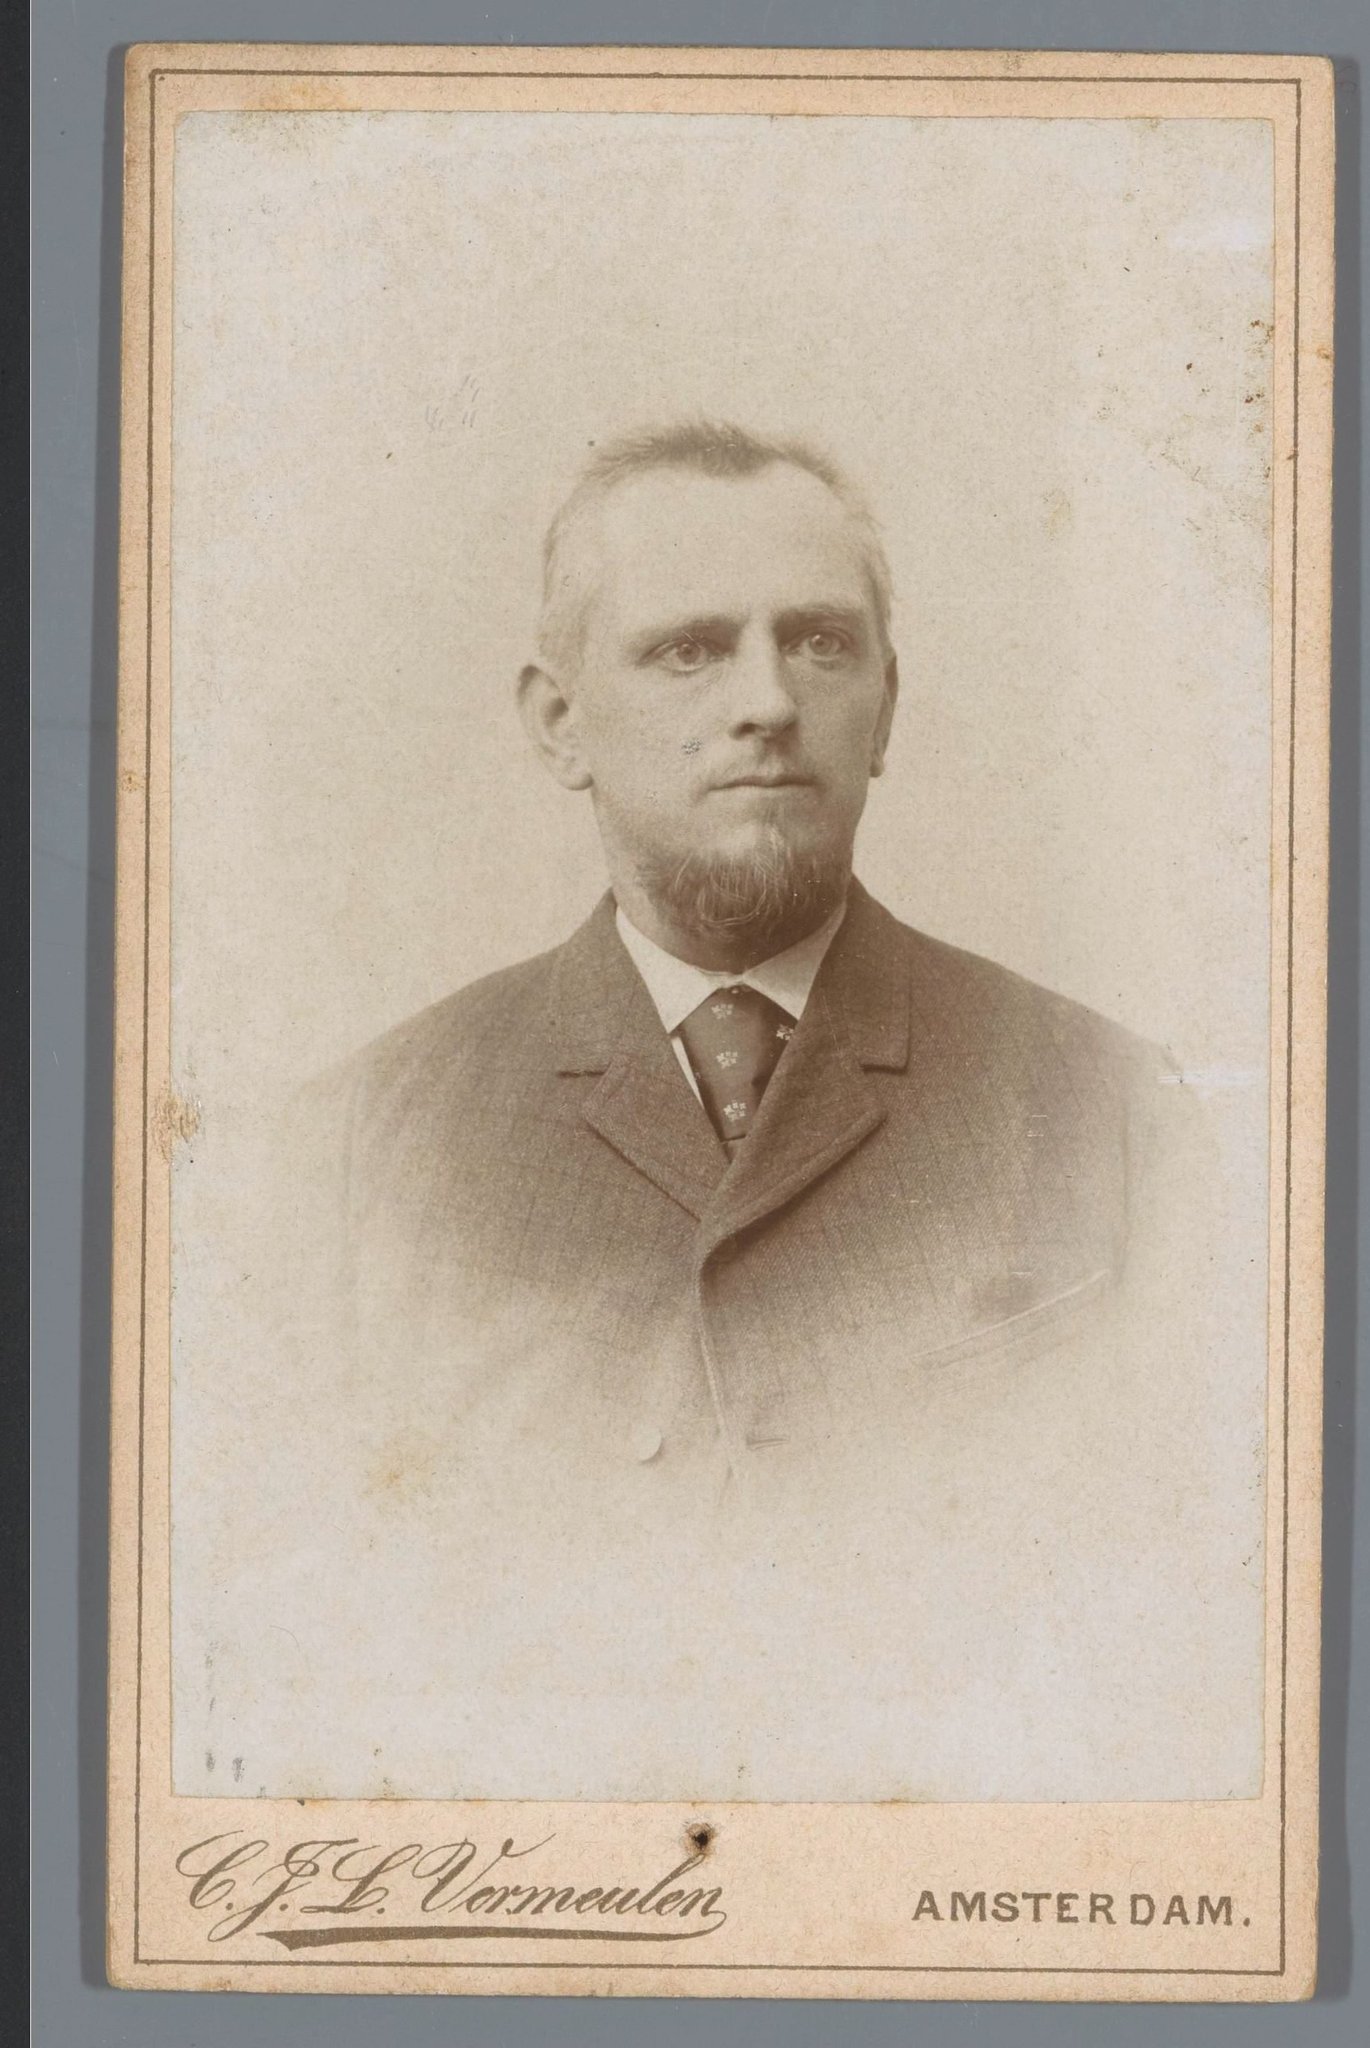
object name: carte de visite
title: Portret van een onbekende man, aangeduid als Dirk de Groot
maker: cornelis johannes lodewicus vermeulen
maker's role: fotograaf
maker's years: 1861-1936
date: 1888-1896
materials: cardboard, photographic support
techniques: collodion silver print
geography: amsterdam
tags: adult man, historical persons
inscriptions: inscription: ‘Photographische/ ATELIERS/ C. J. L. Vermeulen/ Heerenstraat 6,/ Heiligenweg/ hoek Singel/ AMSTERDAM,/ Specialiteit in vergrootingen.’, inscription: ‘Dirk de Groot’